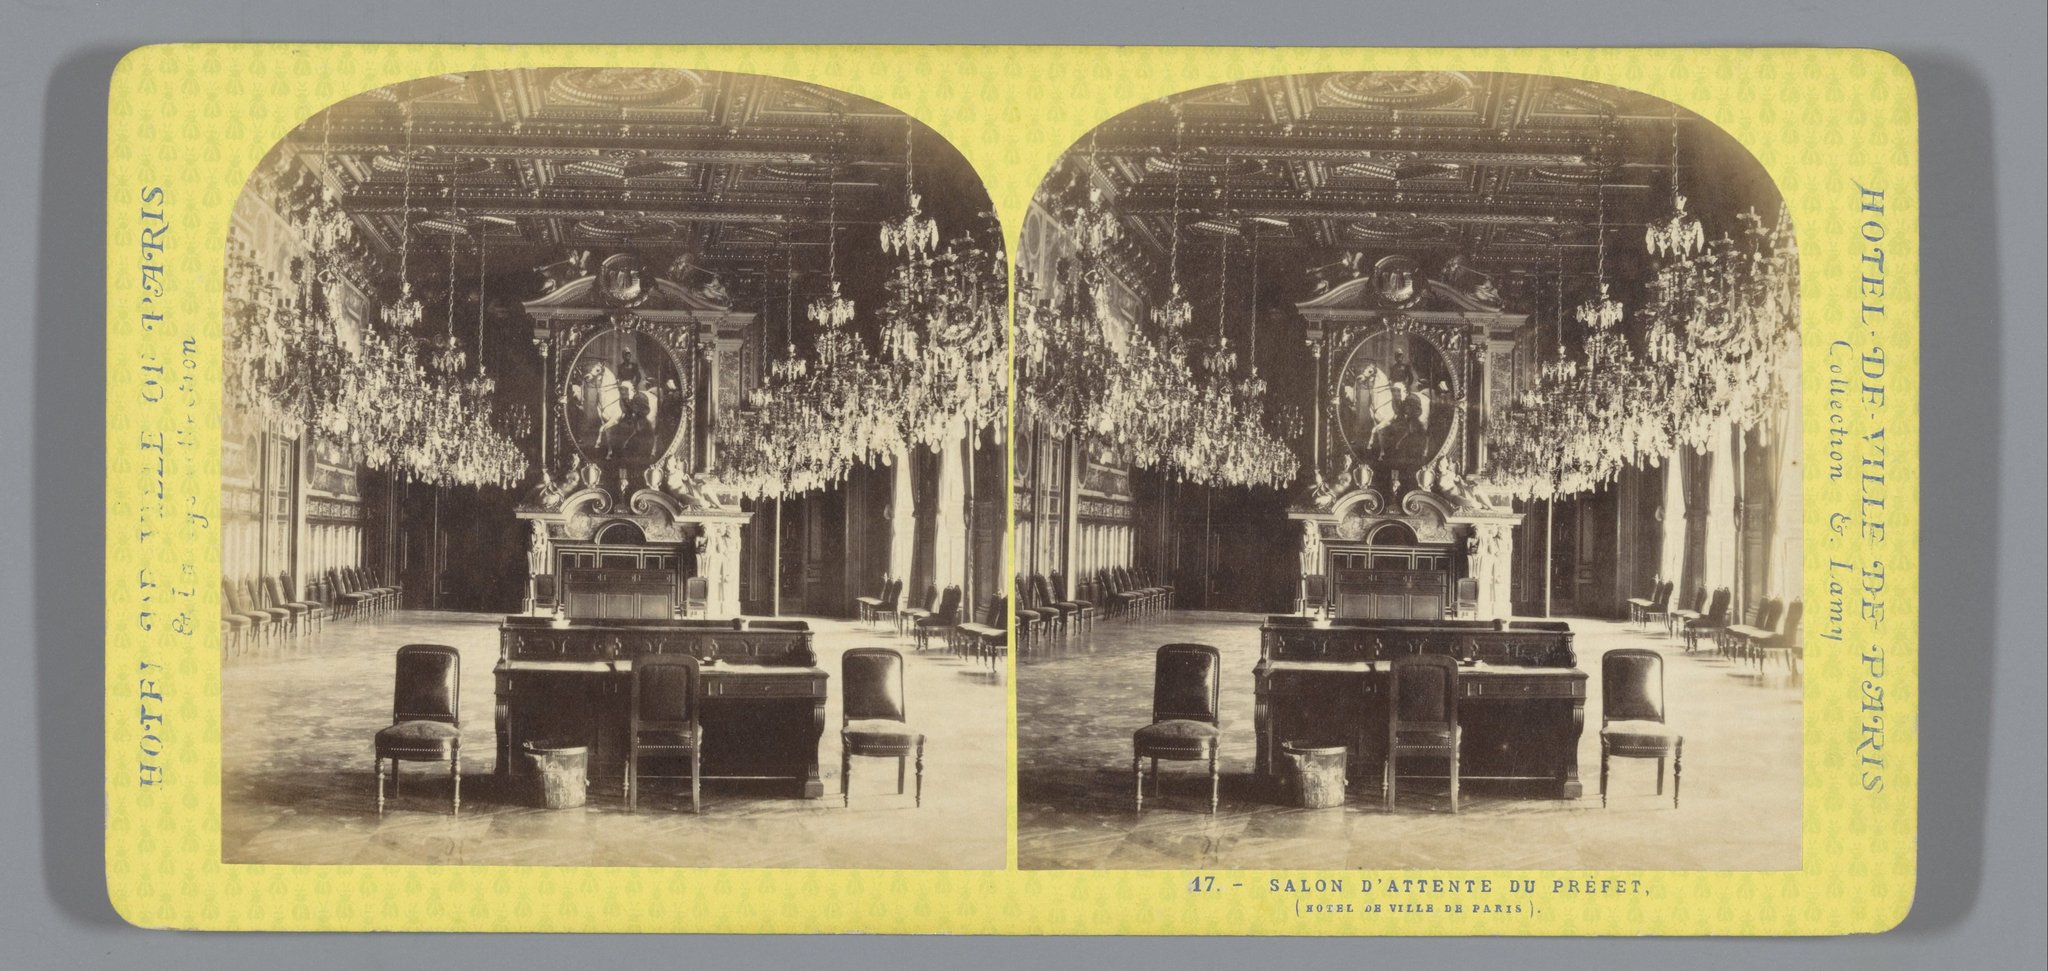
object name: stereograph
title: Salon d'Attente du Prefet, (Hotel de Ville de Paris)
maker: ernest eléonor pierre lamy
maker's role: publisher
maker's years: 1828-1900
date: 1860-1880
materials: cardboard, photographic support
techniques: albumen print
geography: paris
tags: townhall, interior ~ representation of a building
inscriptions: number: ‘17.’, inscription: ‘E. Lamy's collection’